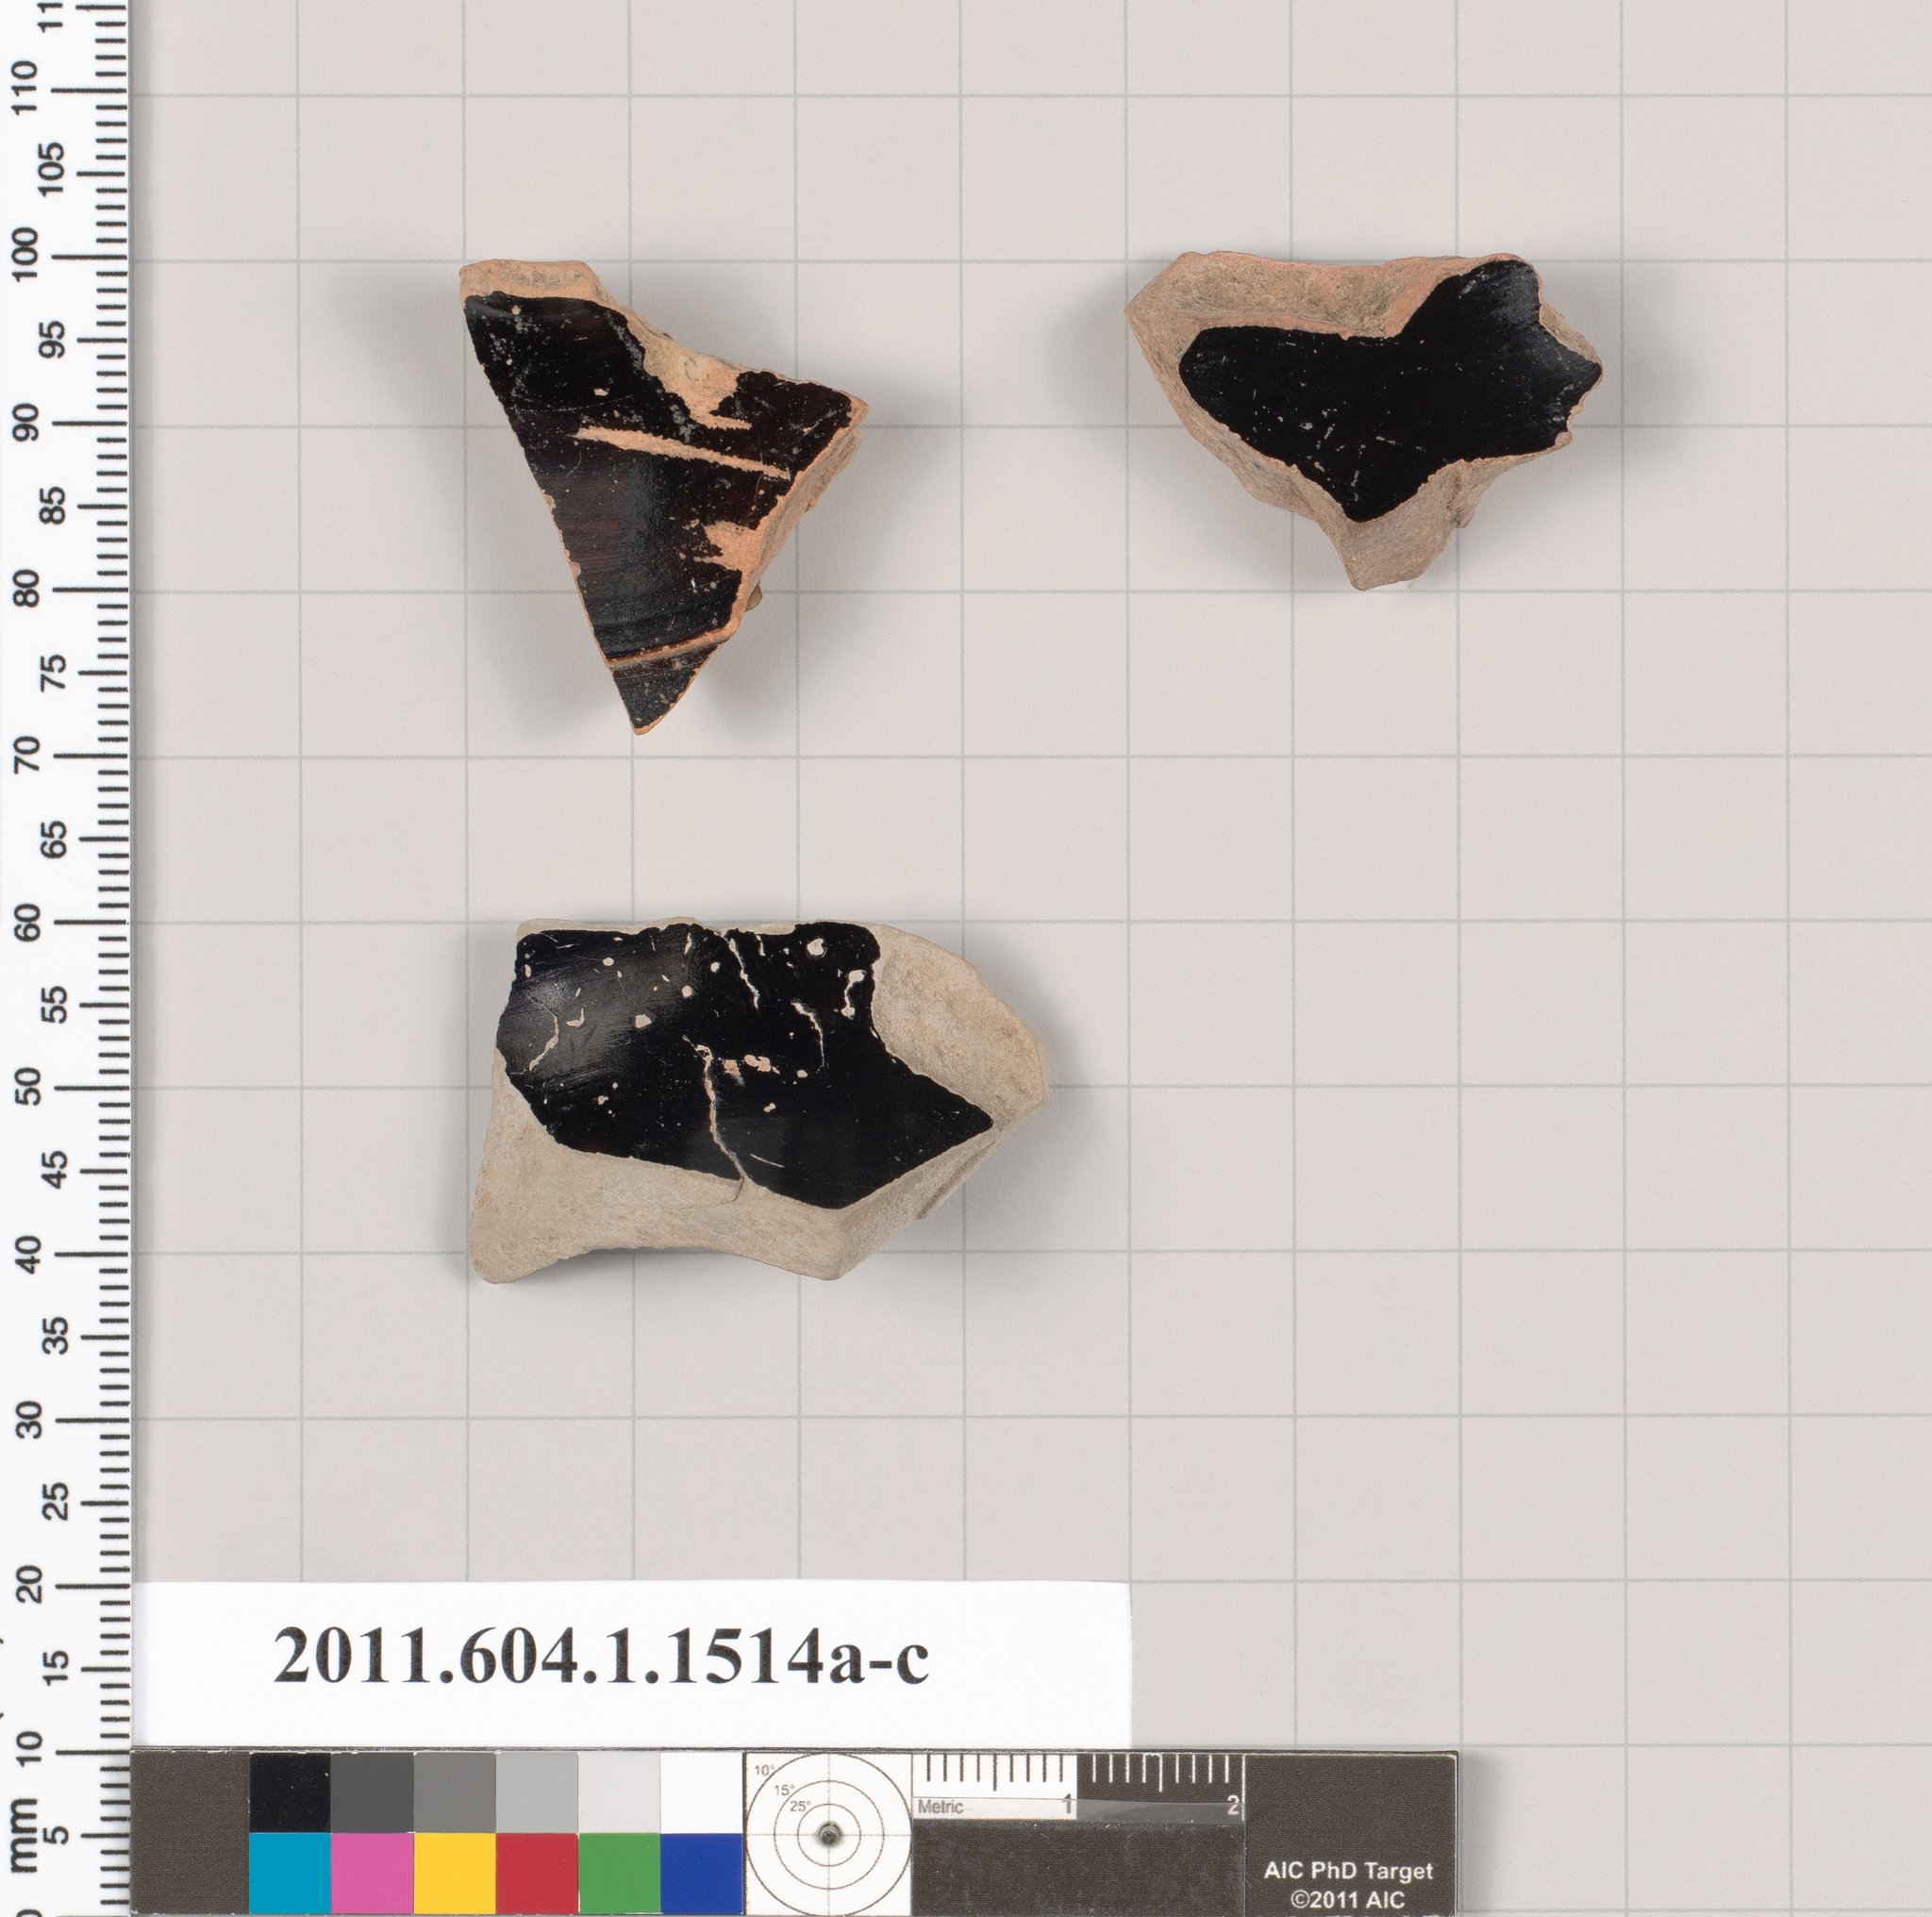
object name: kylix fragment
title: Terracotta fragments of kylikes (drinking cups)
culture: greek, attic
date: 500-401 BCE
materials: terracotta